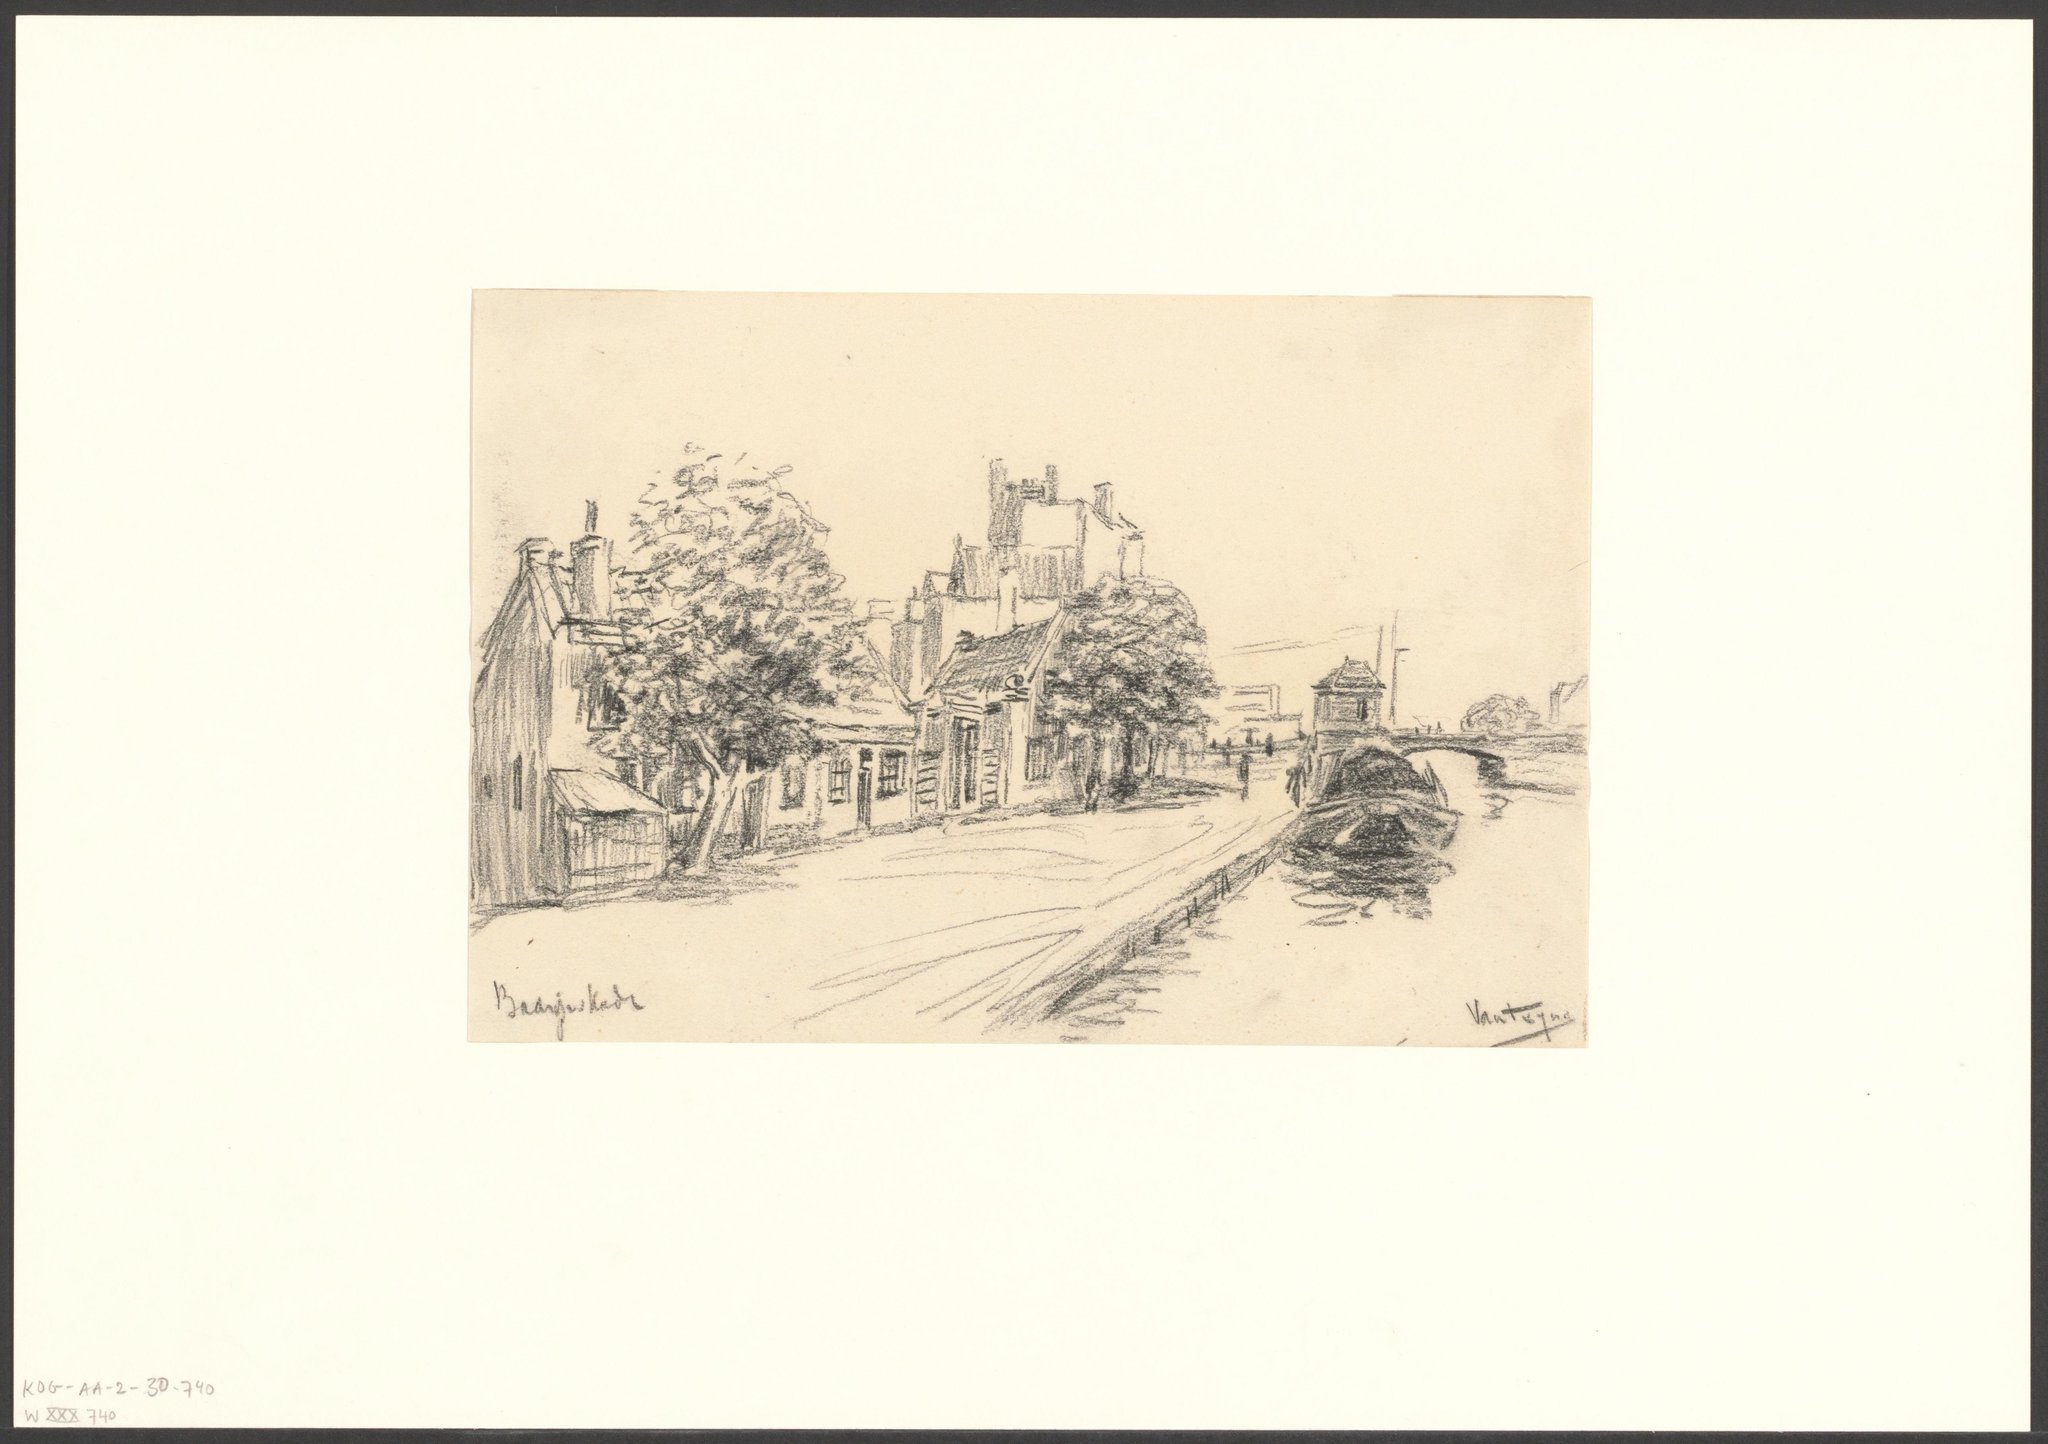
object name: drawing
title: Gezicht op de Baarsjesweg aan de Kostverlorenvaart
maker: anthonie van teijn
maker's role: draughtsman, painter, print maker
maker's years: 1863-1943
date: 1907-1927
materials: chalk, paper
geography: amsterdam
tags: sailing-ship, sailing-boat, city-view in general; 'veduta', canal, road, path, tow-boat, towing-barge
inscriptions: collector's mark: Lugt 800a, inscription: ‘De Baarsjes nabij (...) Juli 1927. / vanEck’, inscription: ‘Baarsjeskade’, signature: ‘VanTeyne’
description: Tekening binnen de Atlas Van Eck ingedeeld op wijknummer 30.